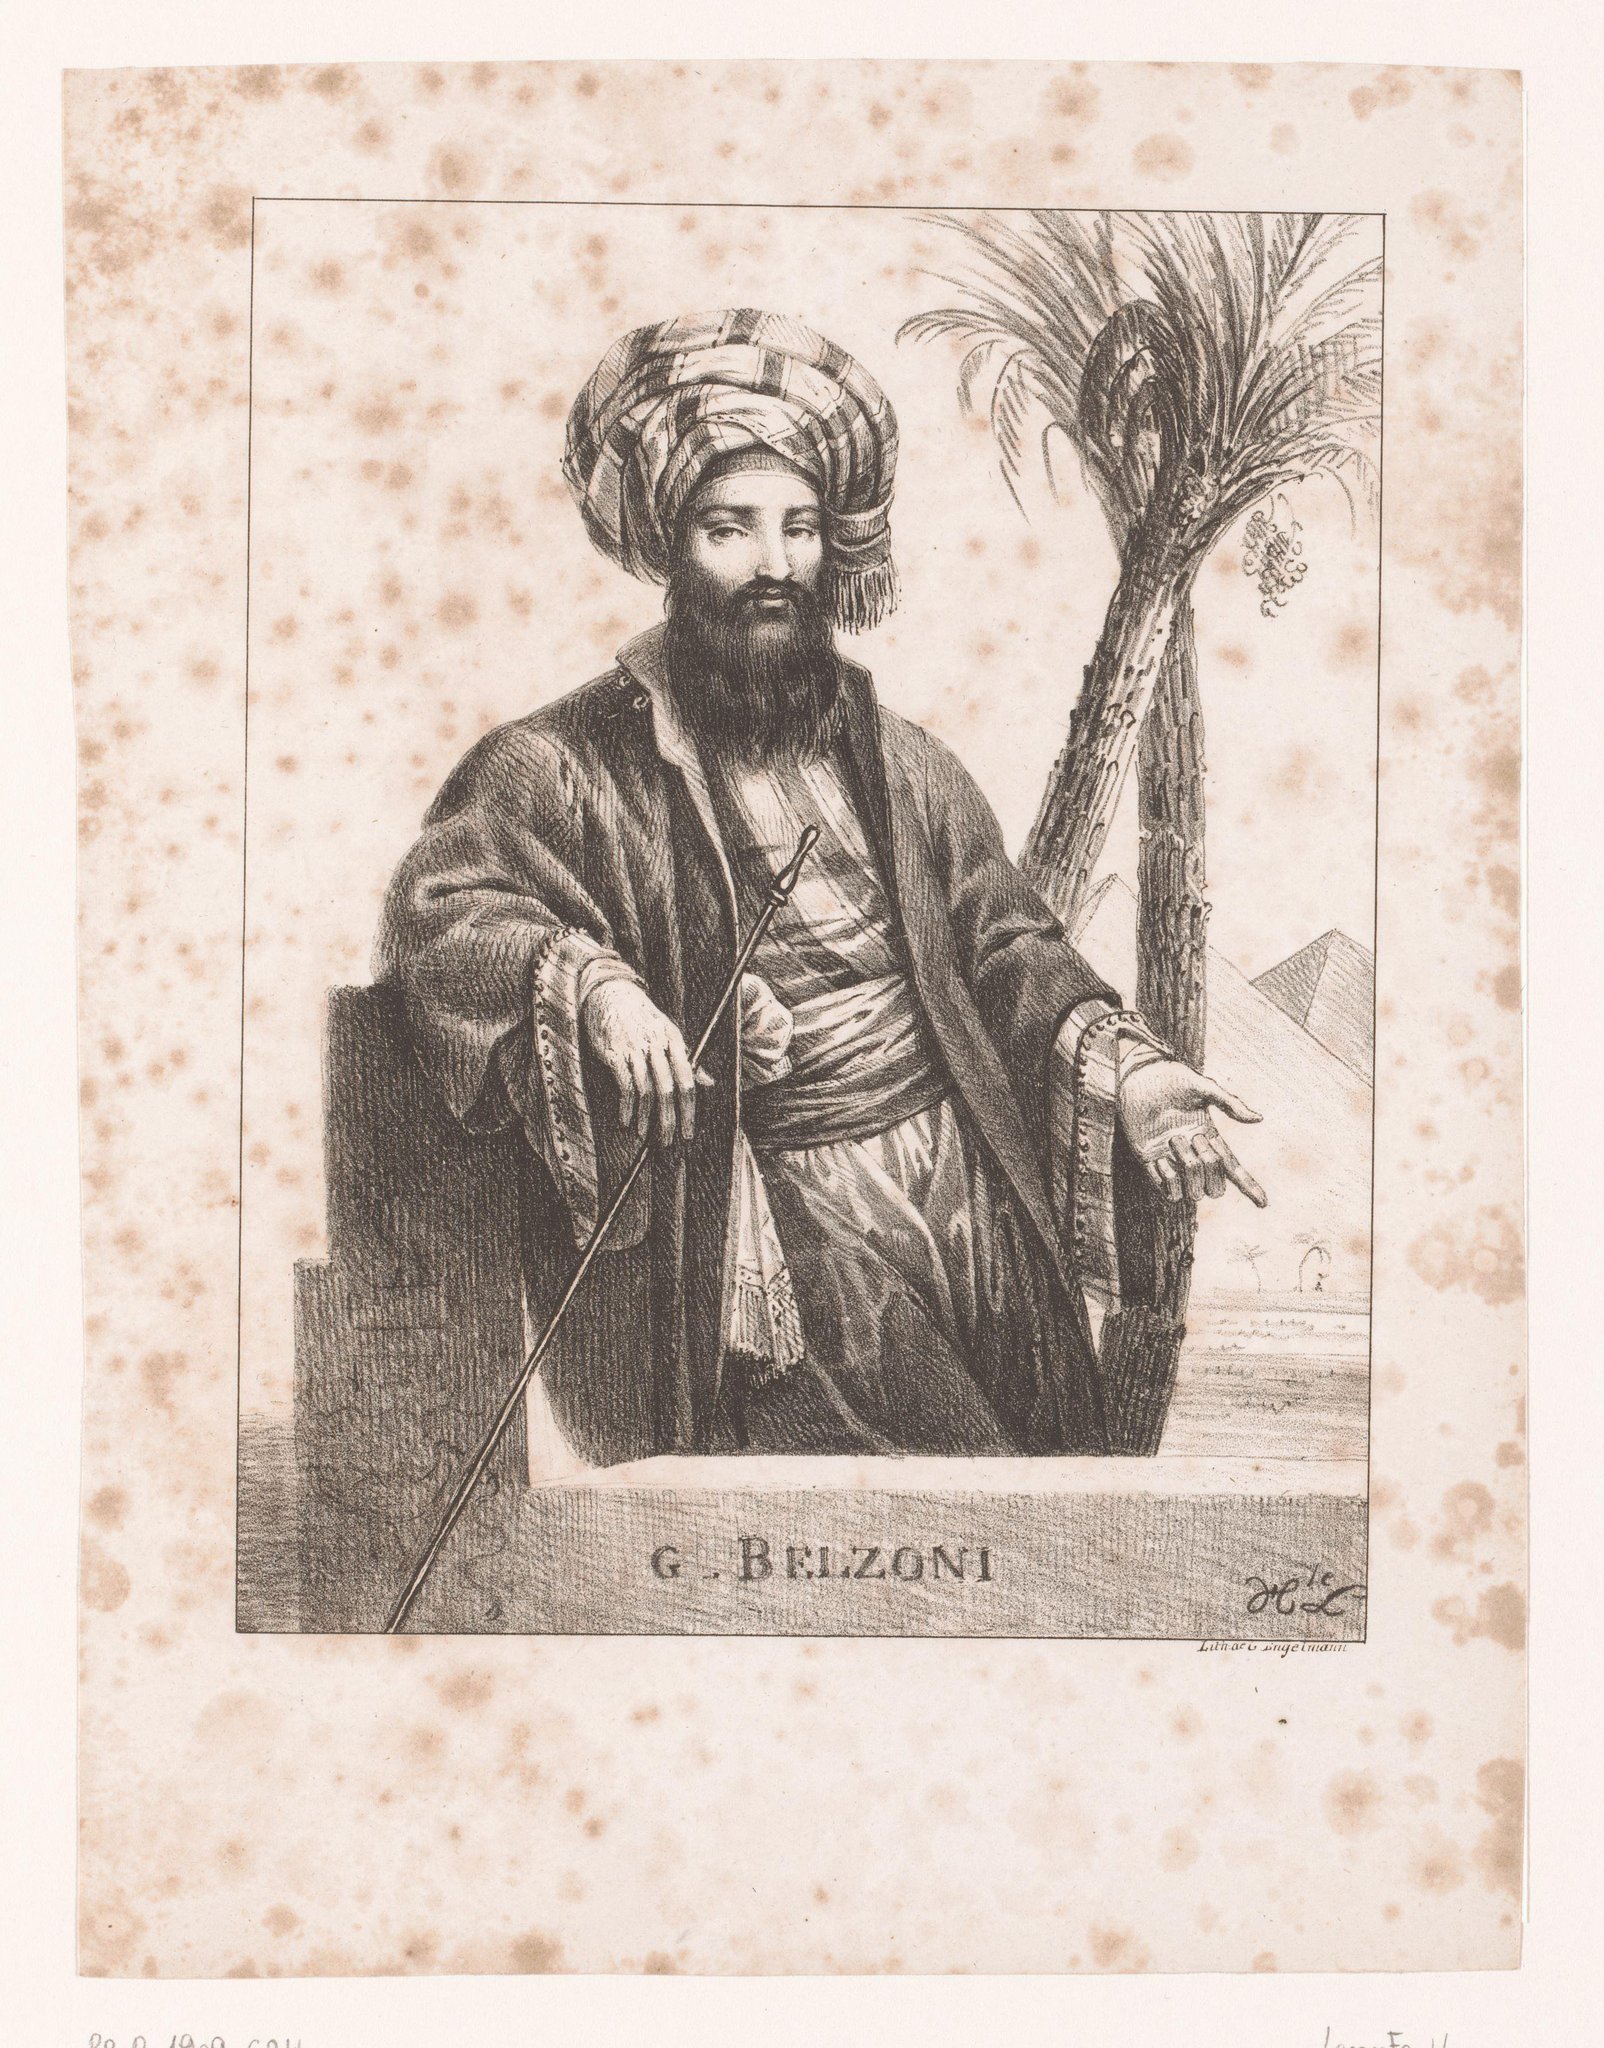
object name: print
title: G. Belzoni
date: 1816-1839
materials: paper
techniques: lithograph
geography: paris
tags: giovanni battista belzoni, historical persons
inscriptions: collector's mark: Lugt 2228a